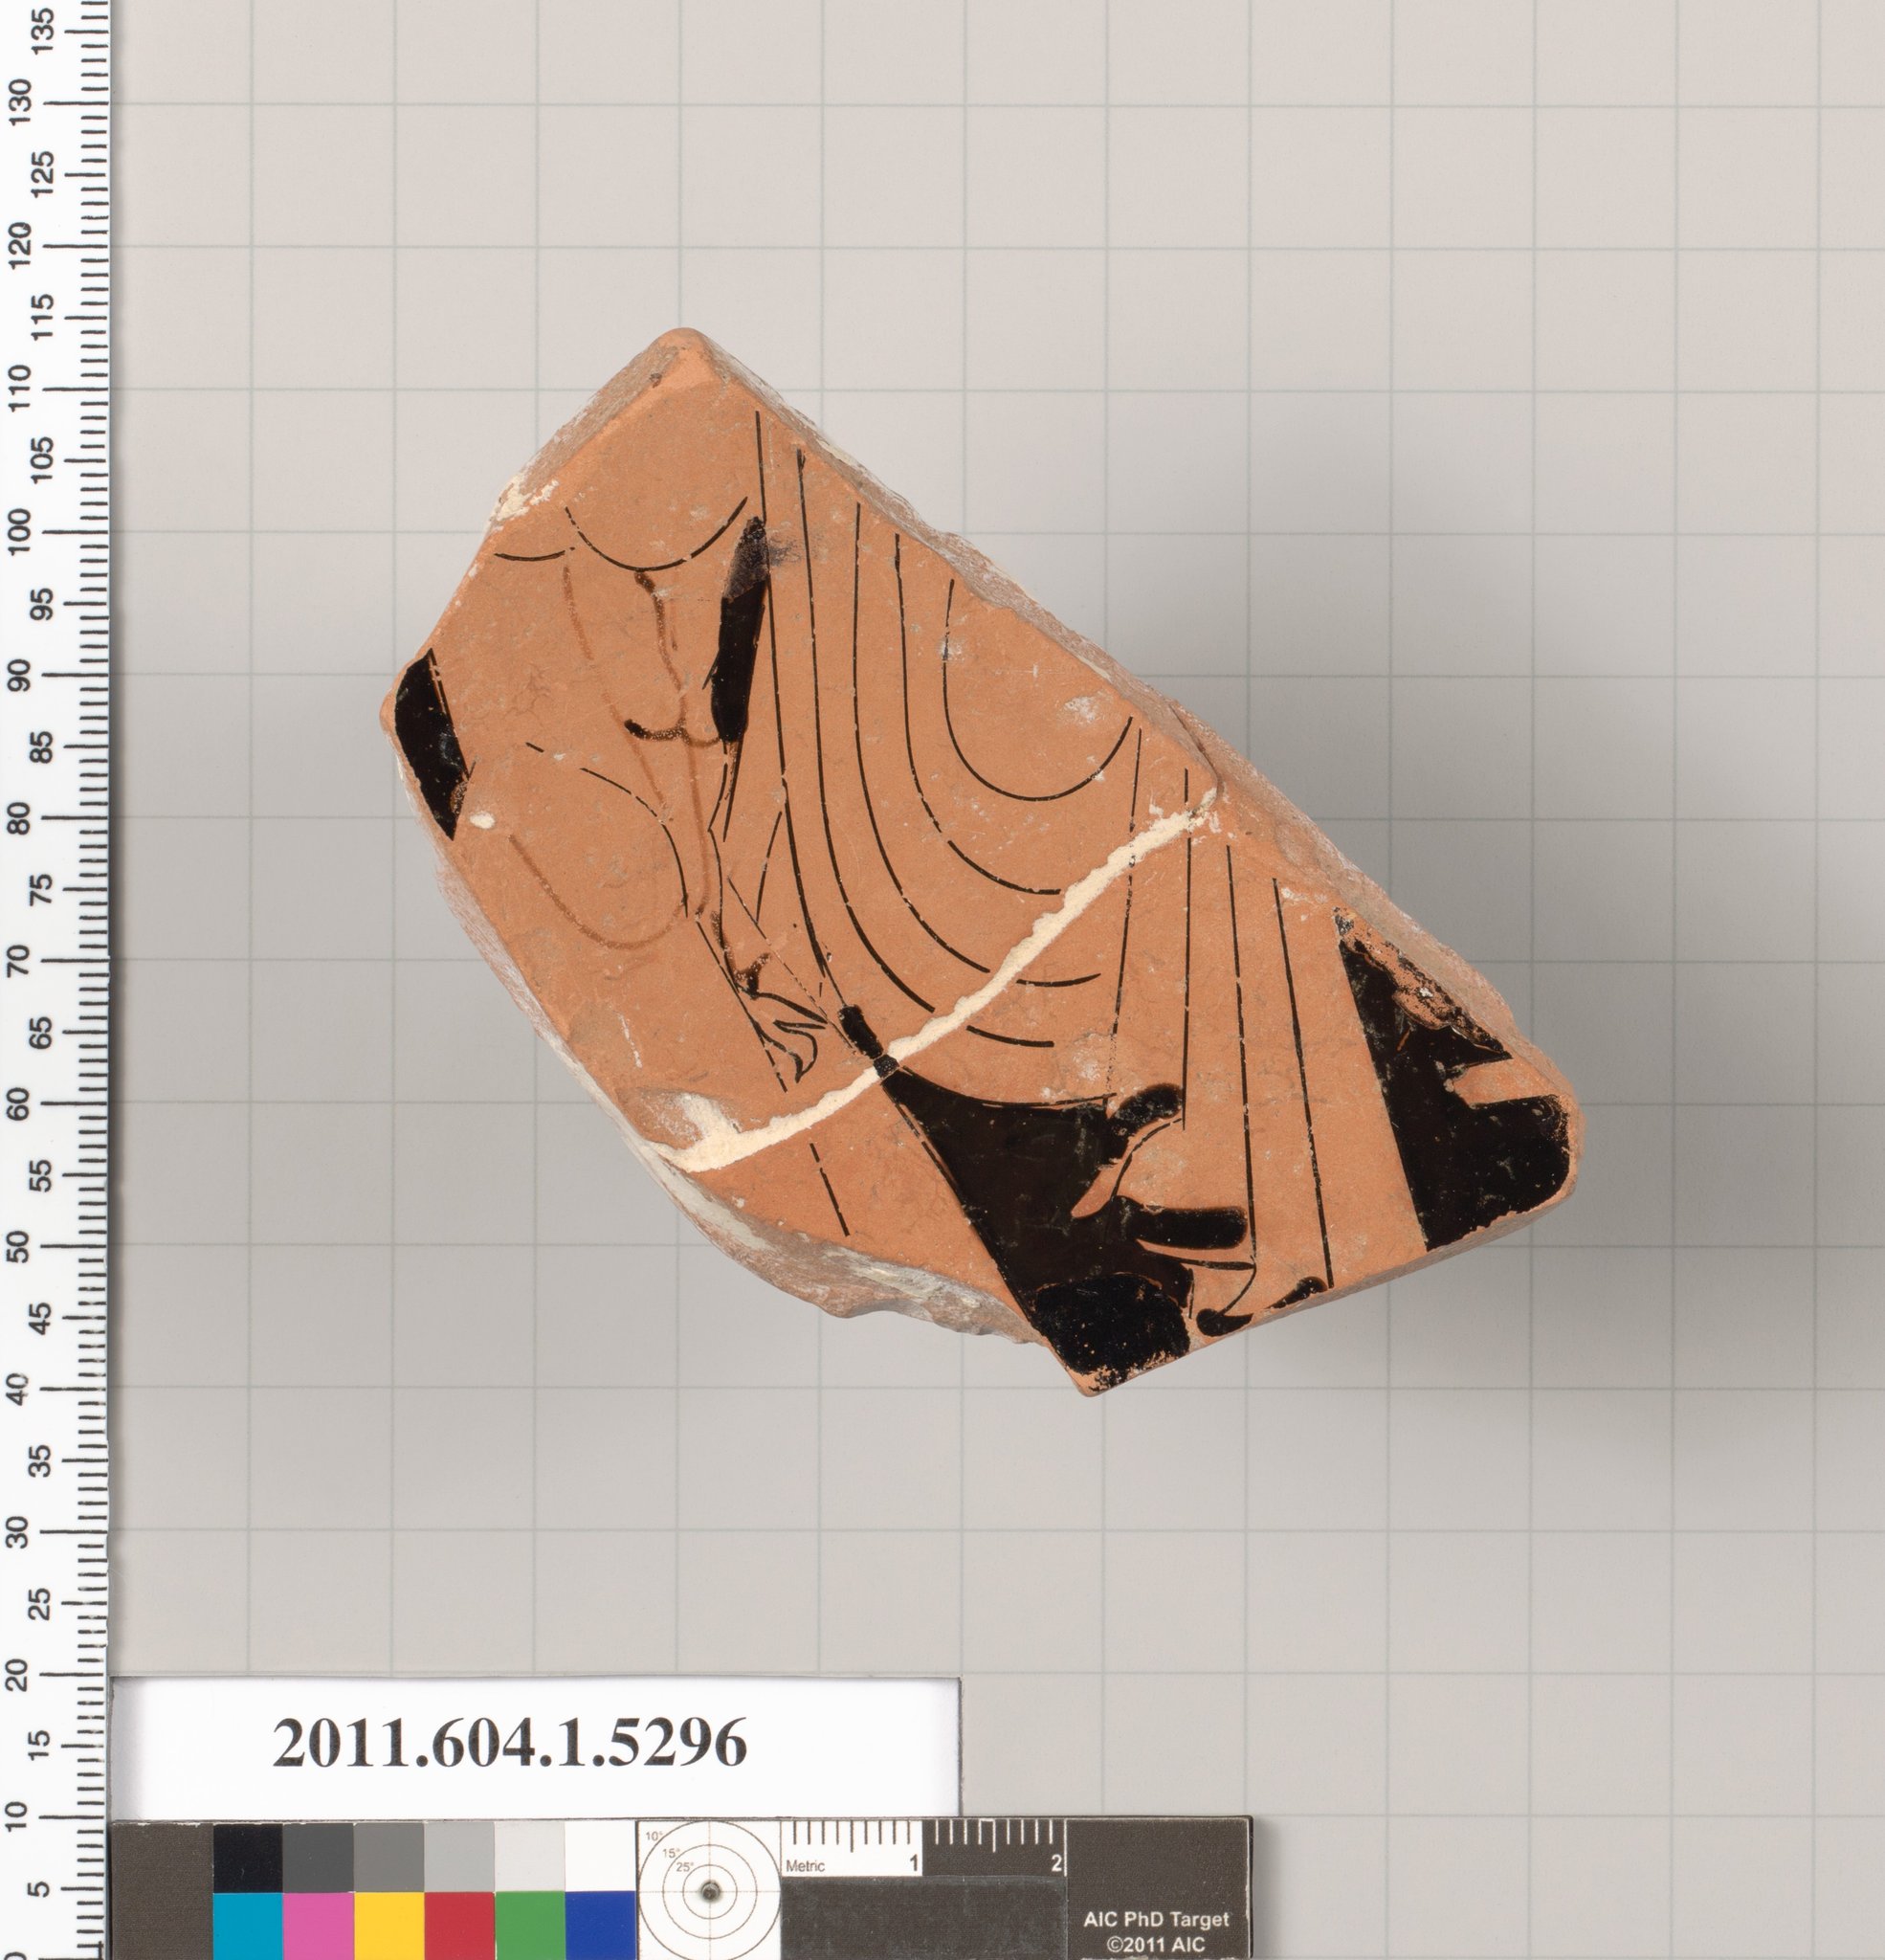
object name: kylix fragment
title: Terracotta fragment of a kylix (drinking cup)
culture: greek, attic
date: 490-470 BCE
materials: terracotta